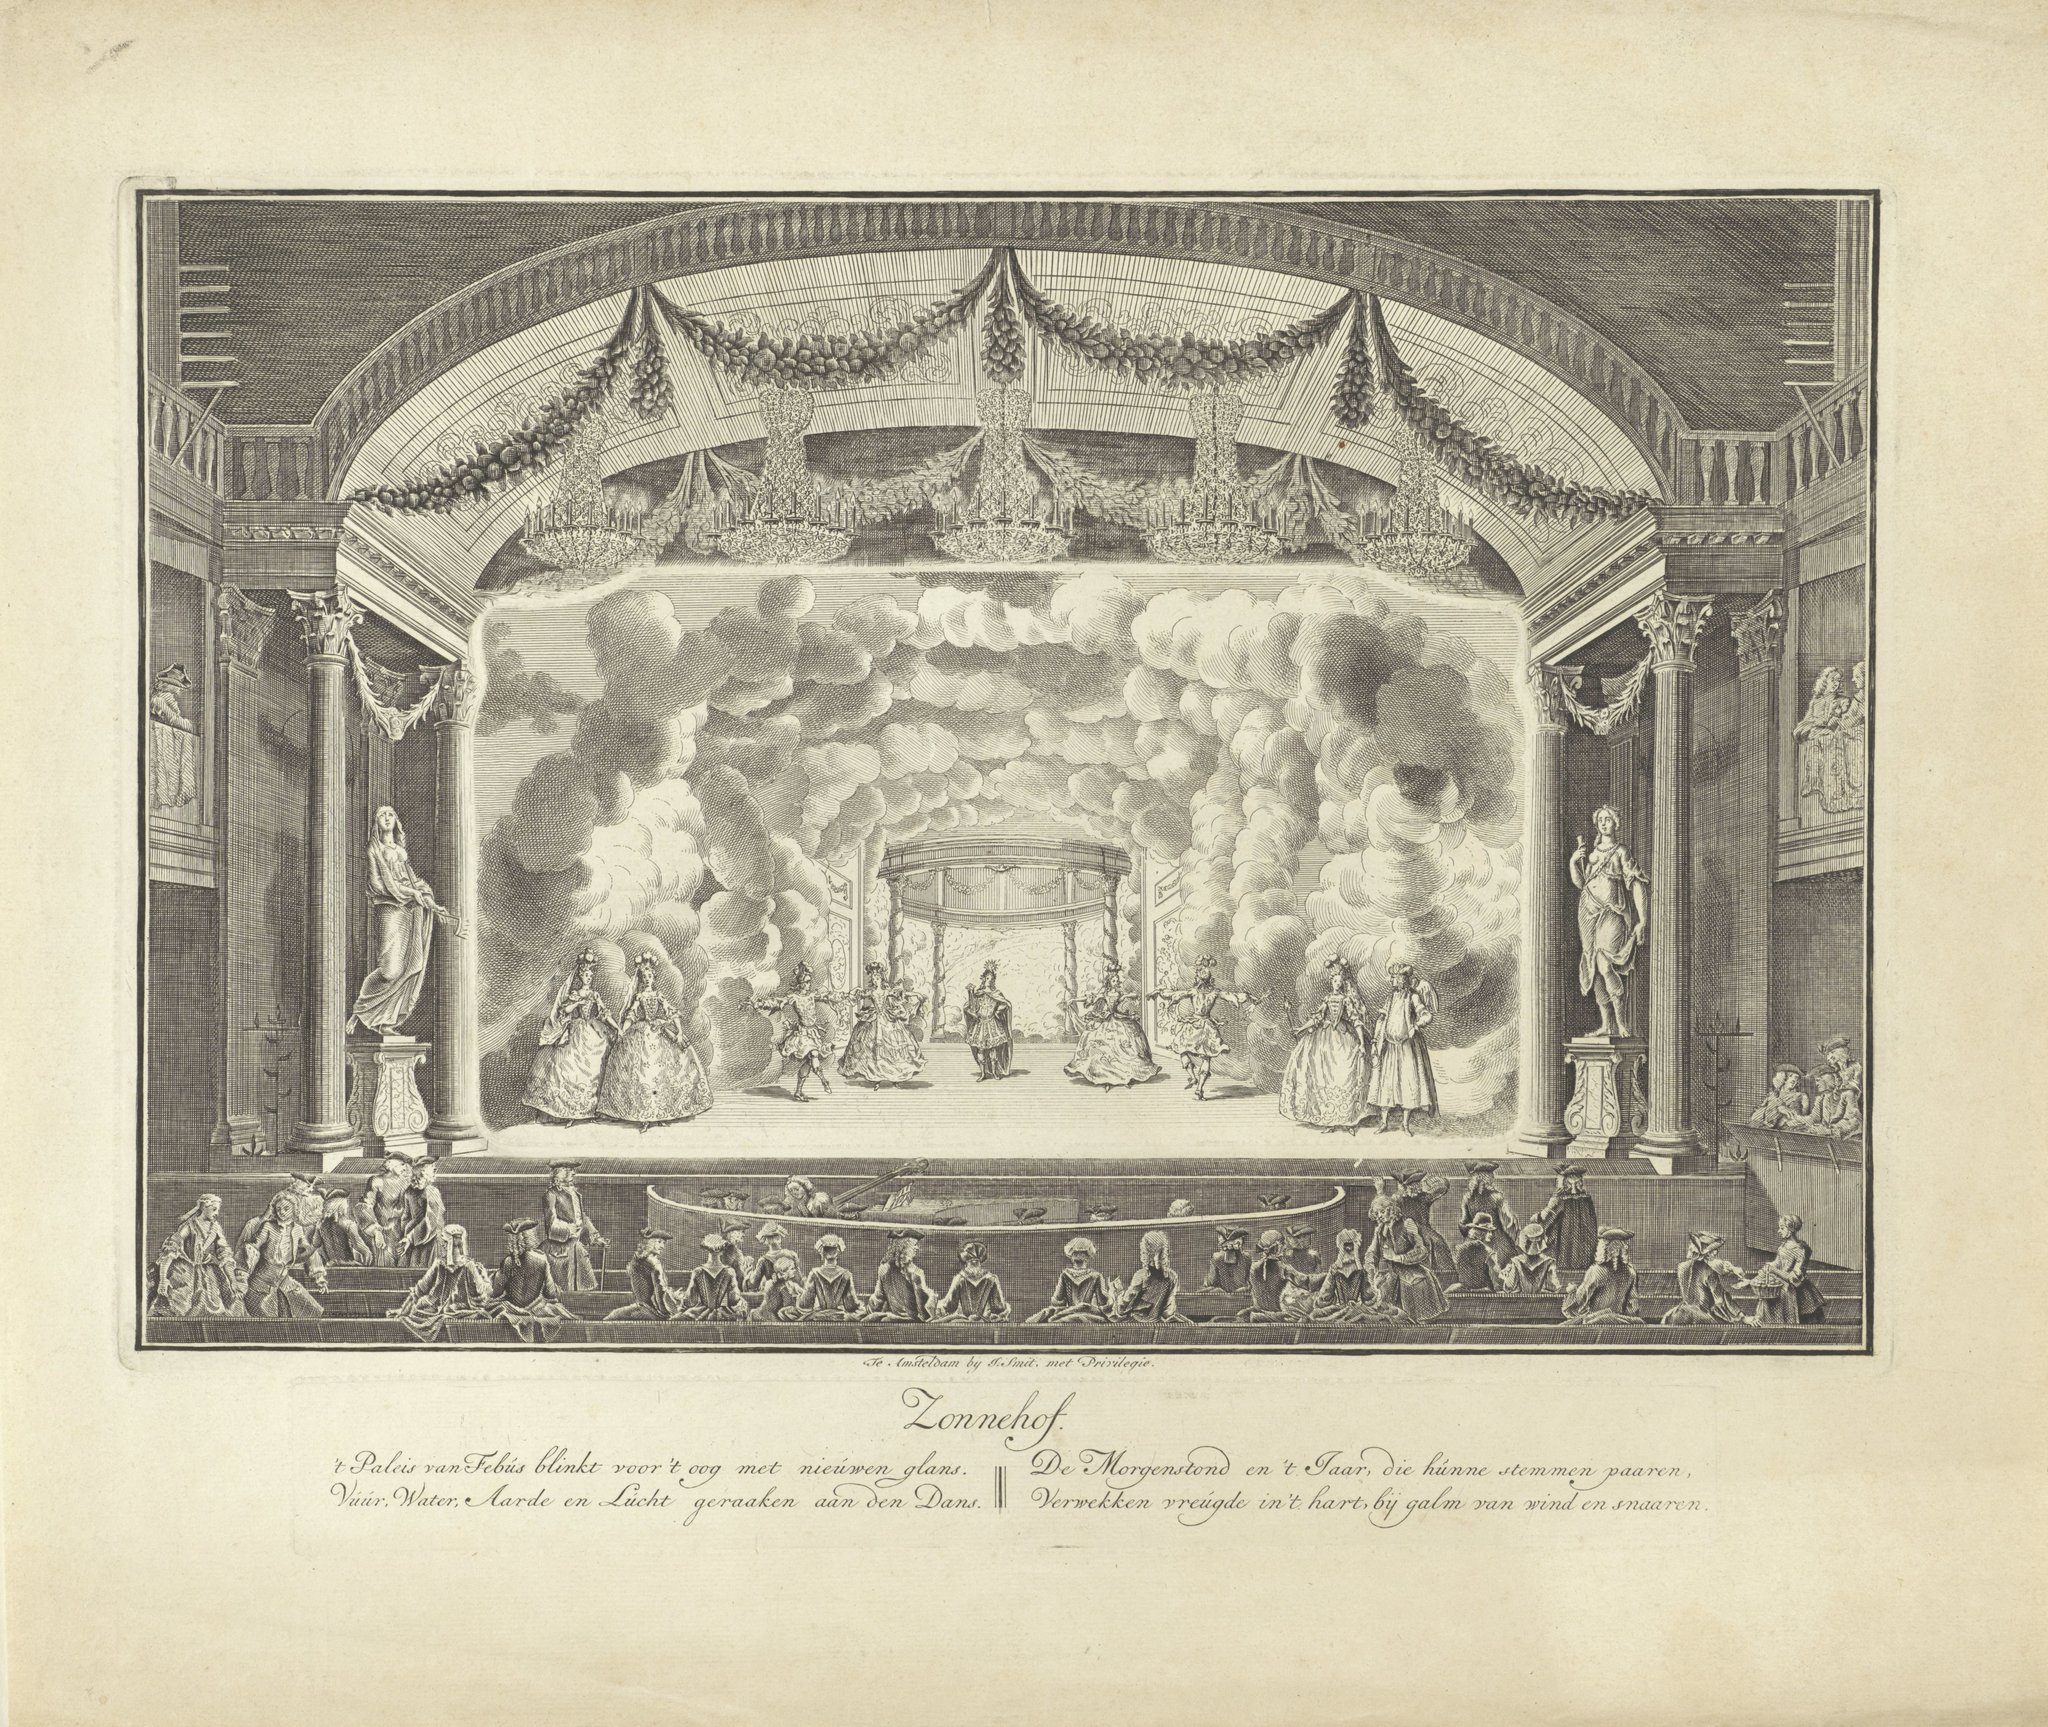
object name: print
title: Schouwburg met toneeldecor: Zonnehof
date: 1738-1740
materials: paper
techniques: engraving, etching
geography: amsterdam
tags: theatre, theatrical performance, stage design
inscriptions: collector's mark: Lugt 2228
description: Toneelvoorstelling in de Amsterdamse Schouwburg op de Keizersgracht met het coulissendecor Zonnehof met scène uit: Het eeuwgetijde van den Amsteldamschen Schouwburg. Het decor gedrukt van een aparte plaat binnen een passe-partout met de zaal, zijloges, orkestbak en de façade van het toneel met zuilen, guirlandes en kroonluchters. De titel en een vierregelig vers ook gedrukt van een aparte plaat. Onderdeel van een serie van twaalf toneeldecors.